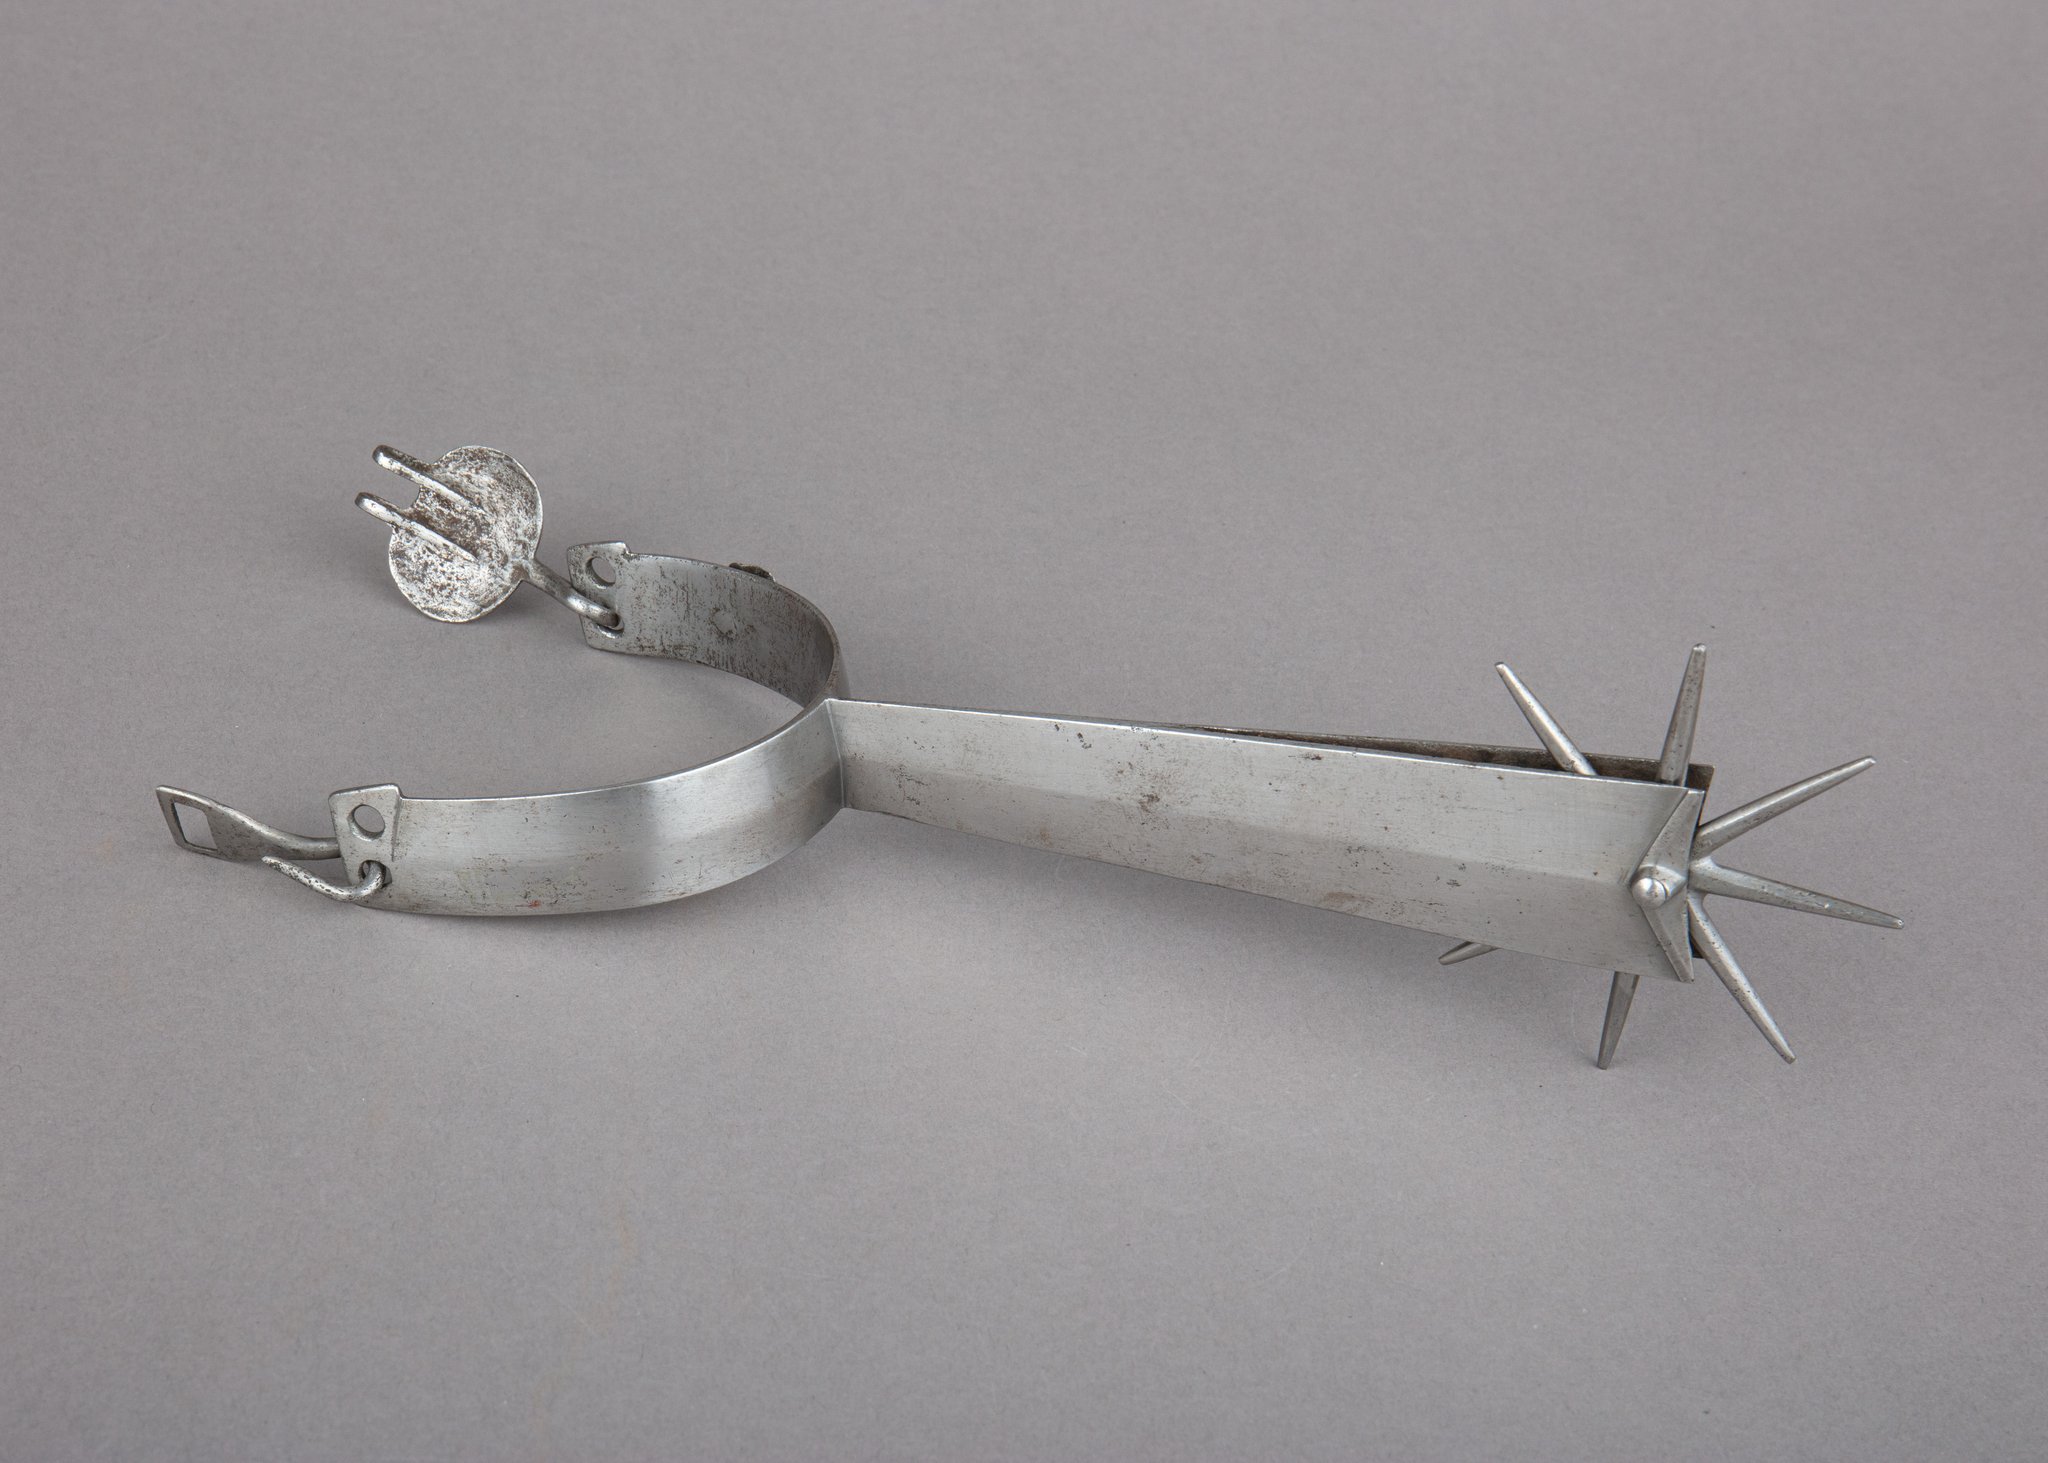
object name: spur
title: Hussar Rowel Spur (Right)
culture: hungarian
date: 1501-1600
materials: metal alloy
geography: hungary